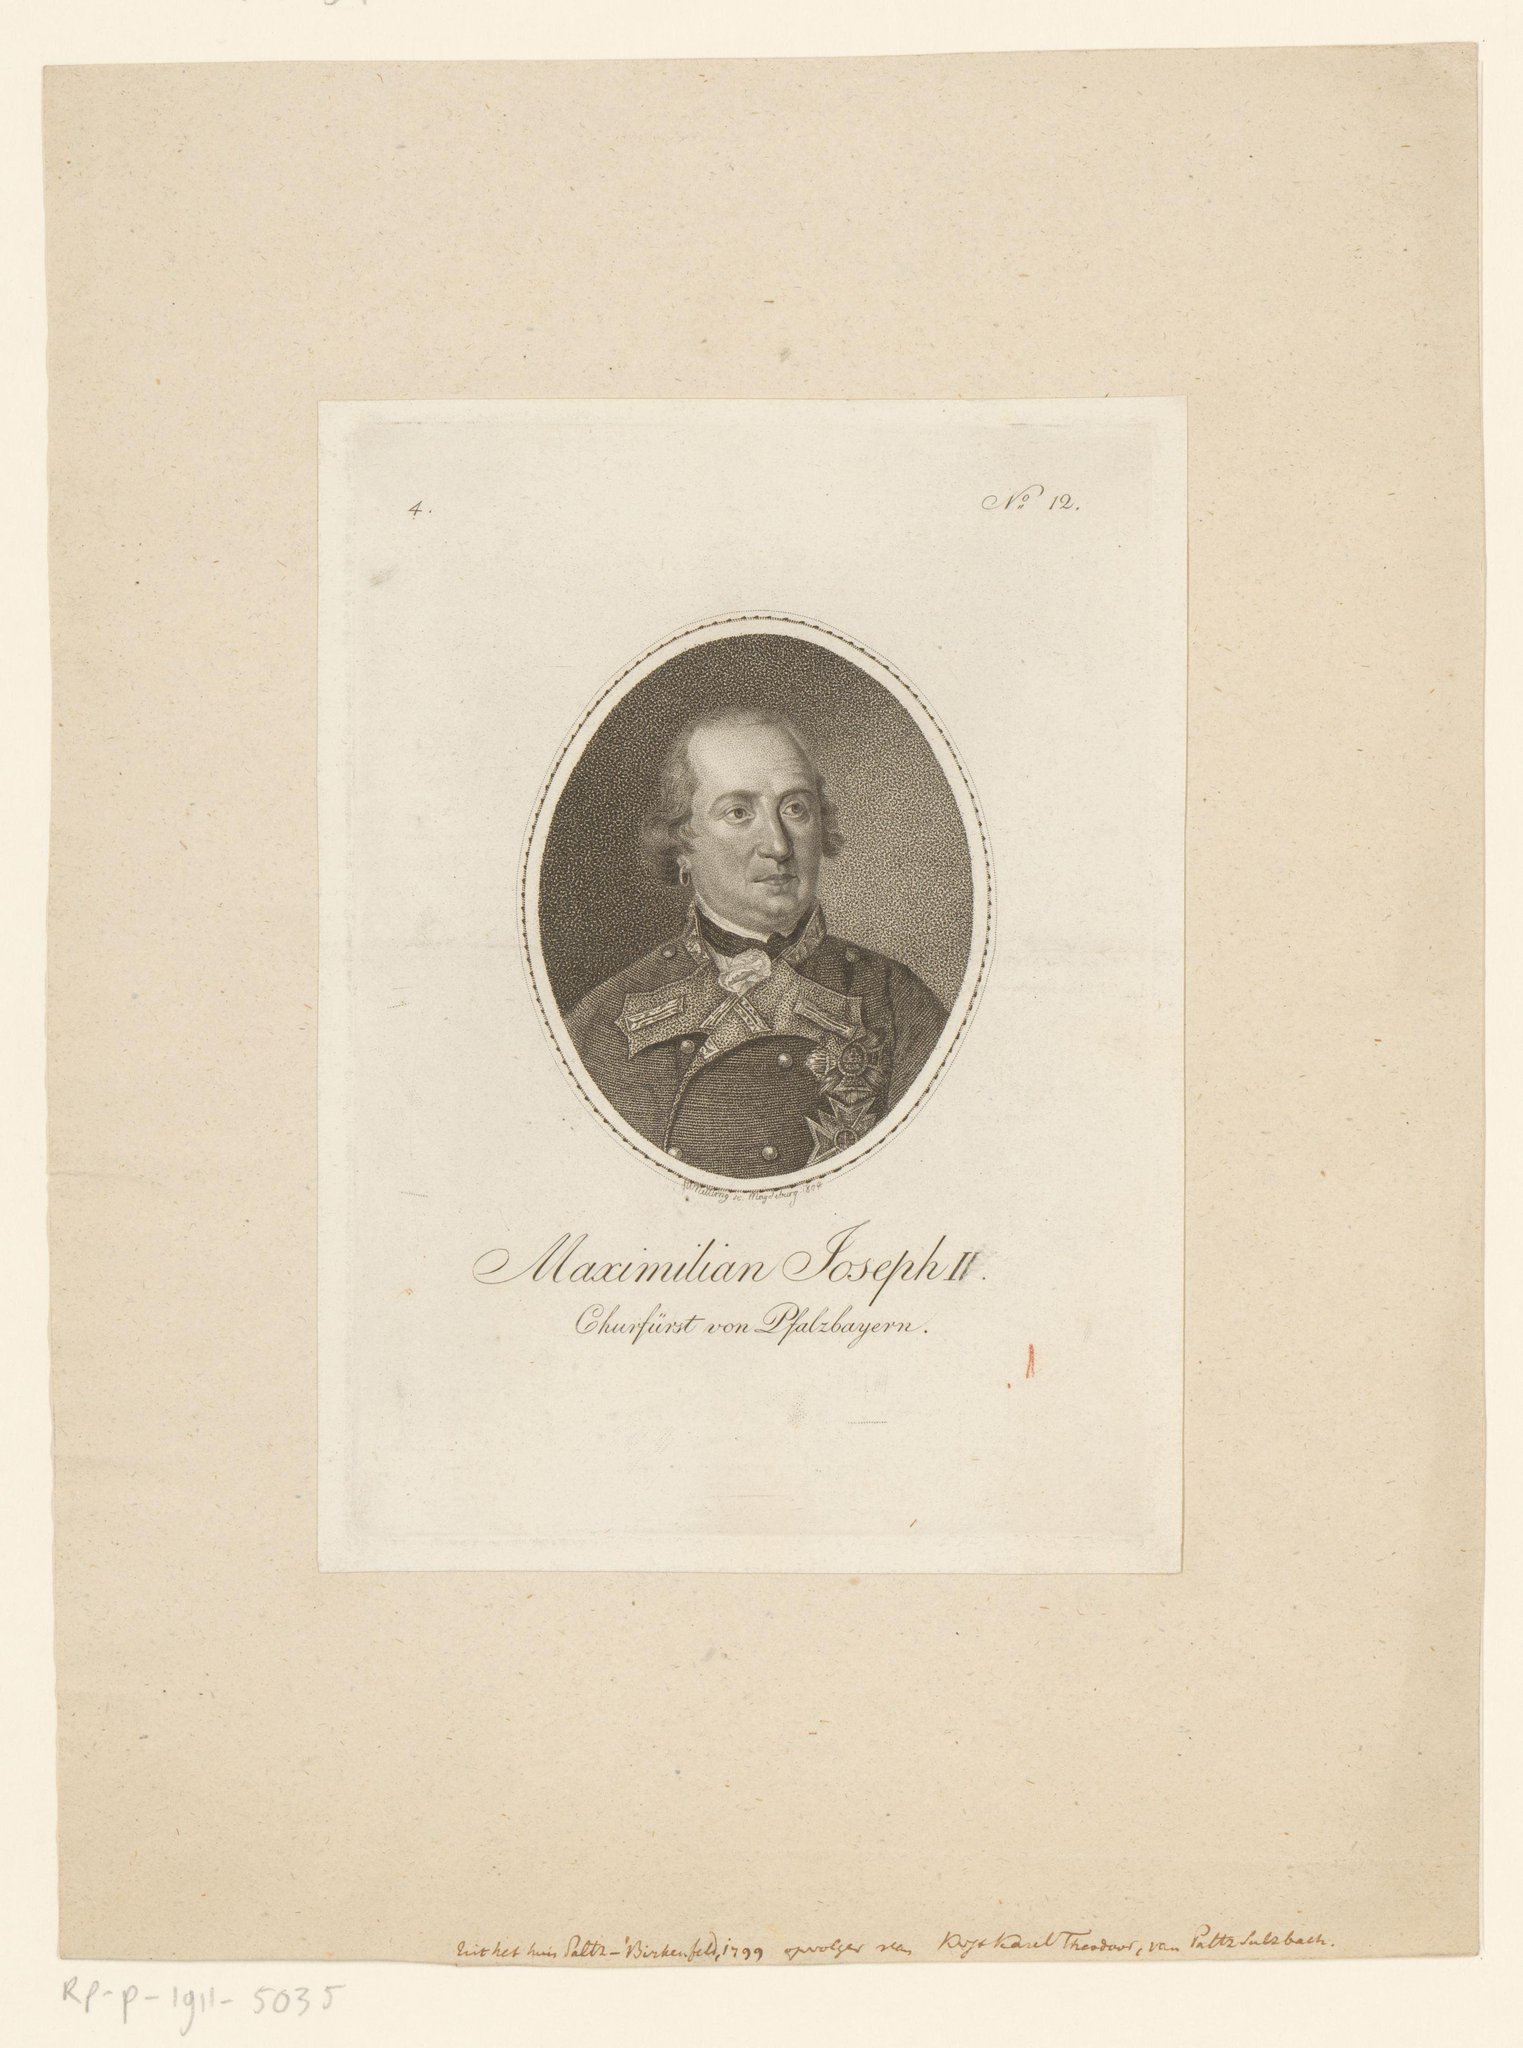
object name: print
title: Portret van Maximiliaan I Jozef, keurvorst van Beieren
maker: friedrich wilhelm nettling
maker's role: print maker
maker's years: 1793-1824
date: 1799-1824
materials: paper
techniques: engraving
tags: maximiliaan i jozef (koning van beieren), historical persons, medals and other marks of military honour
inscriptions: collector's mark: Lugt 2228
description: Linksboven gedrukt 4. En rechtsboven No. 12.